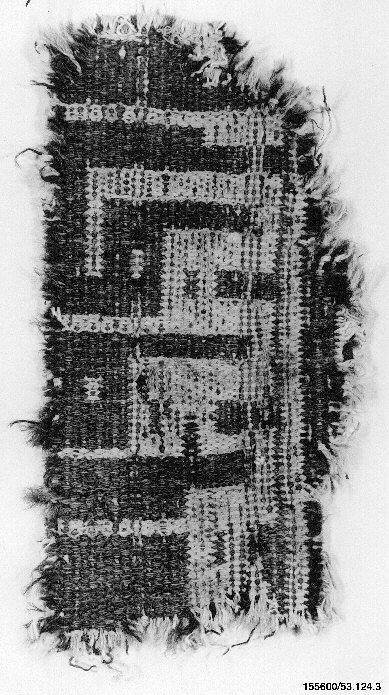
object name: textile fragment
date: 701-900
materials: wool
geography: egypt